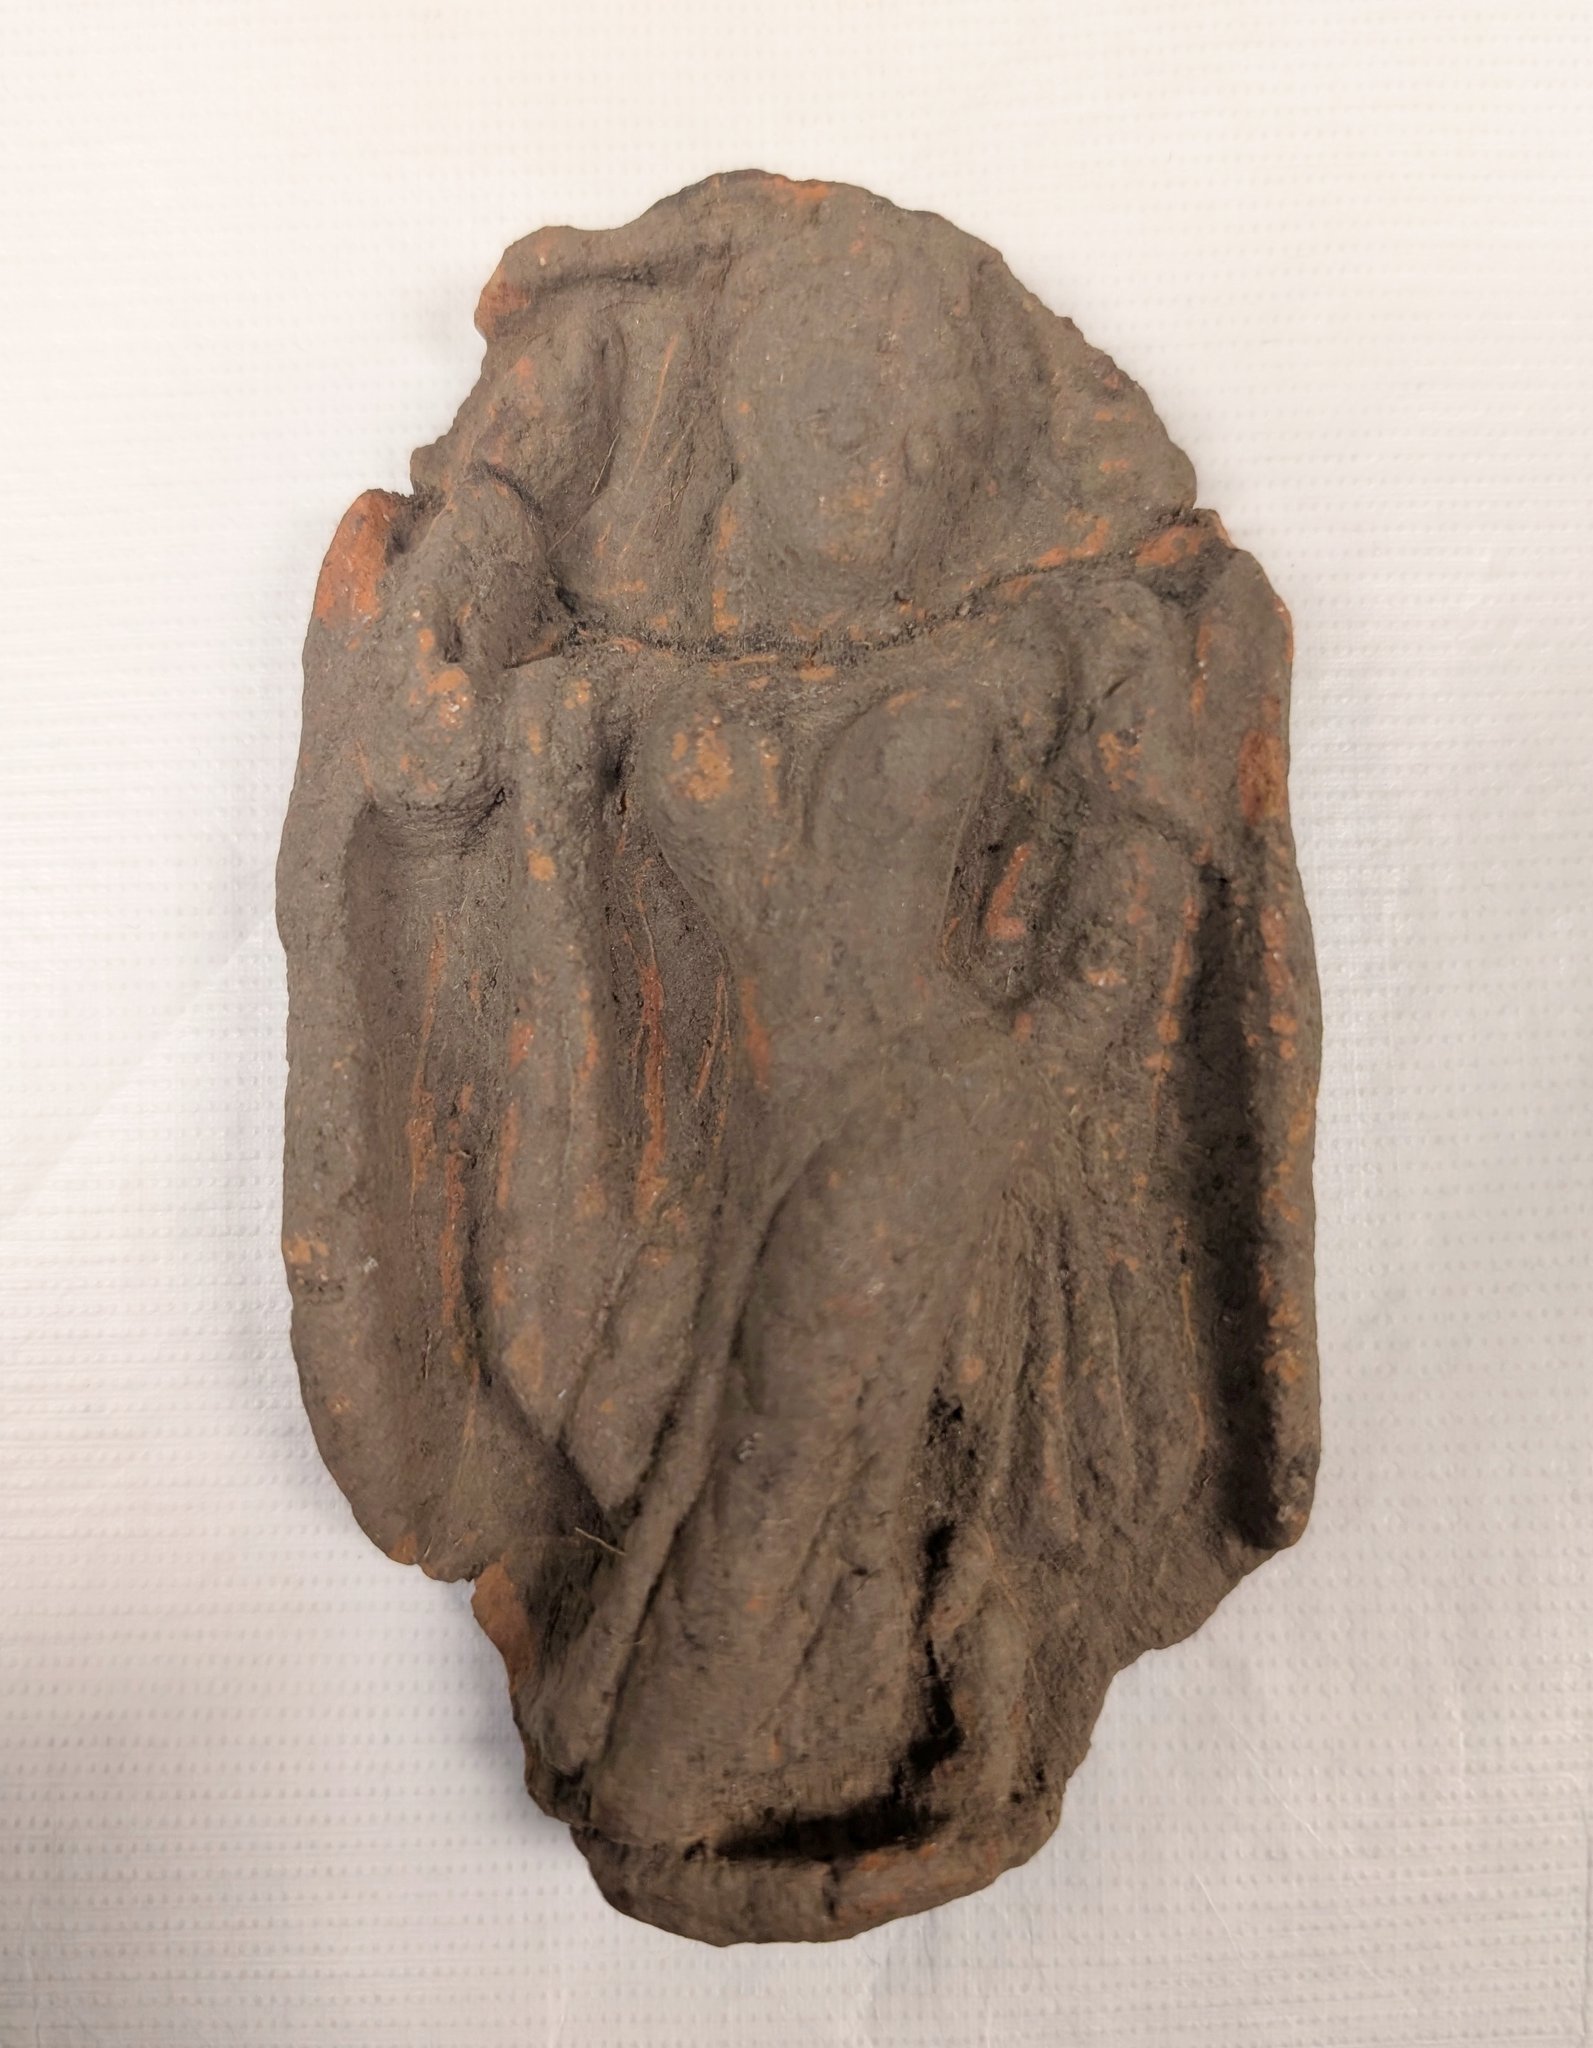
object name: plaque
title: Plaque in the Form of a Female Figure (Study Collection)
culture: pakistani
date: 101-300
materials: terracotta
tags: gandhara